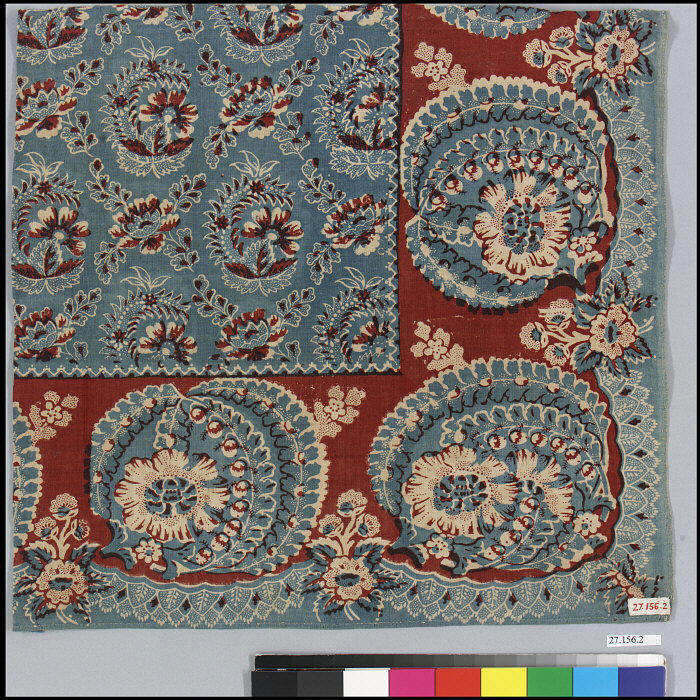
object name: fragment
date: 1801-1833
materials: cotton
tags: flowers,leaves